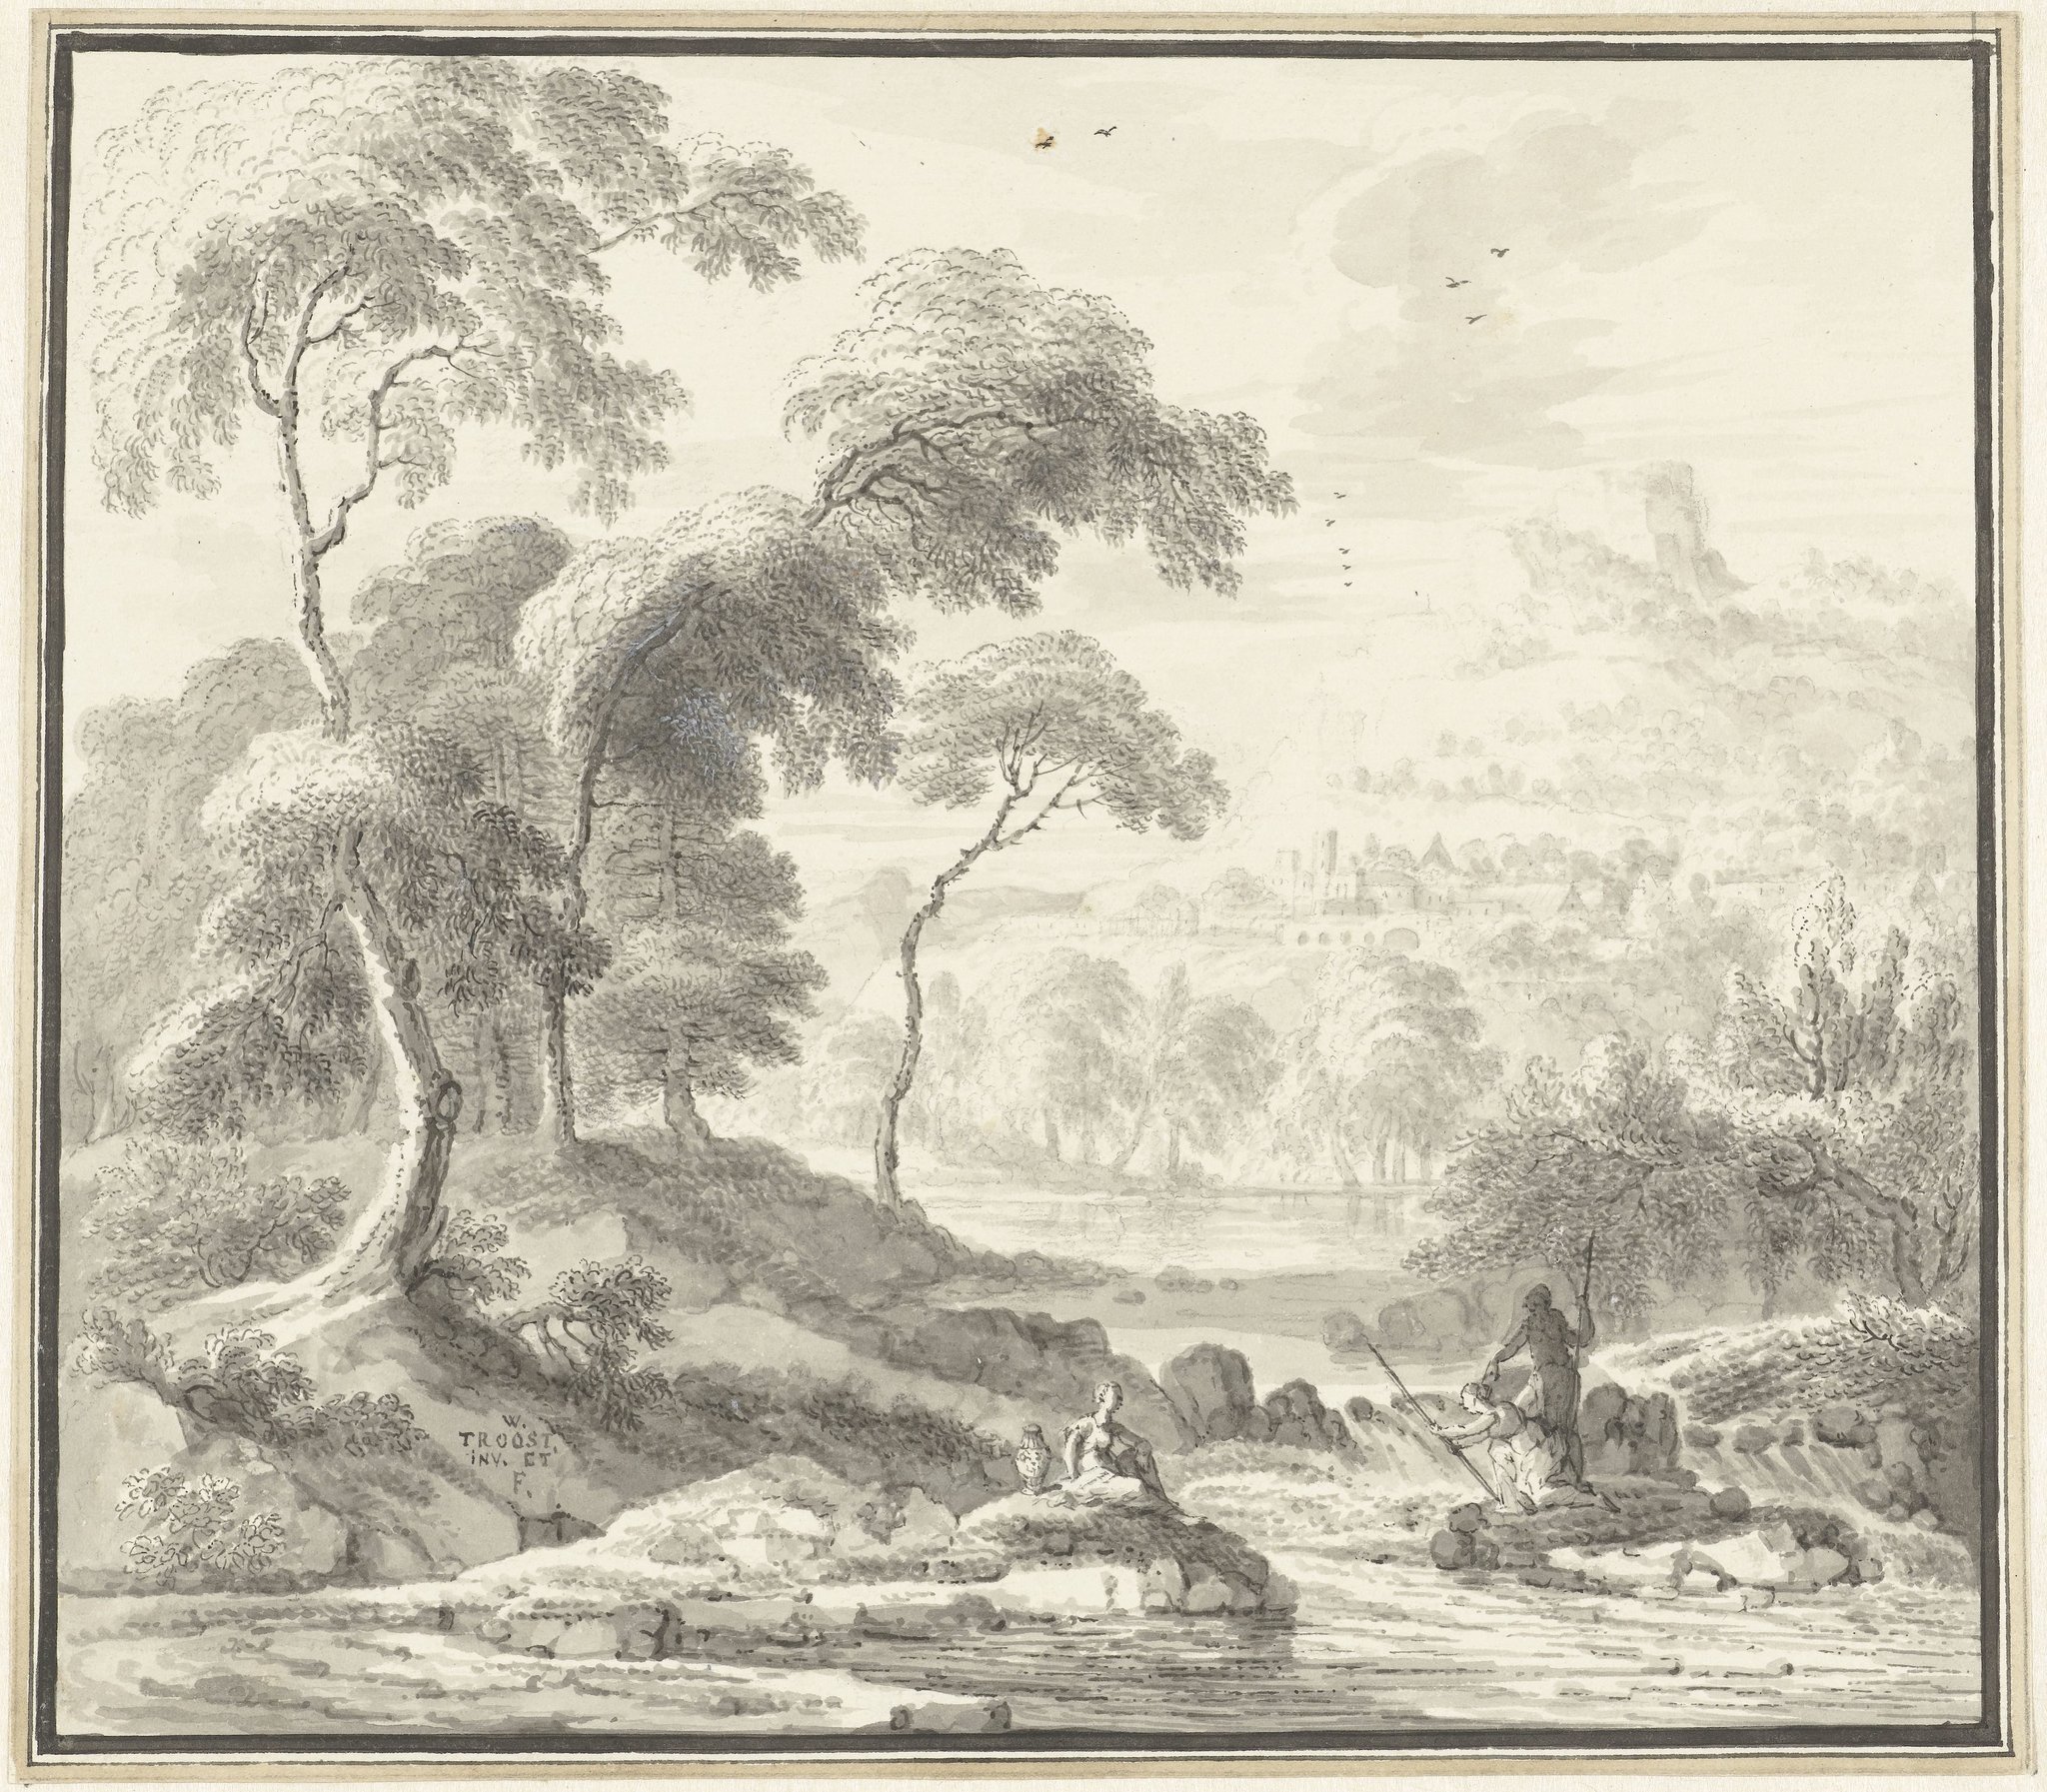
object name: drawing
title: Idyllisch heuvellandschap met vrouwen aan een stroom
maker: willem troost (i)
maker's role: draughtsman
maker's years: 1684-1752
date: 1694-1752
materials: ink, paper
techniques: pen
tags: landscapes - hh - ideal landscapes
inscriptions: signature: ‘W. TROOST. INV. ET F.’